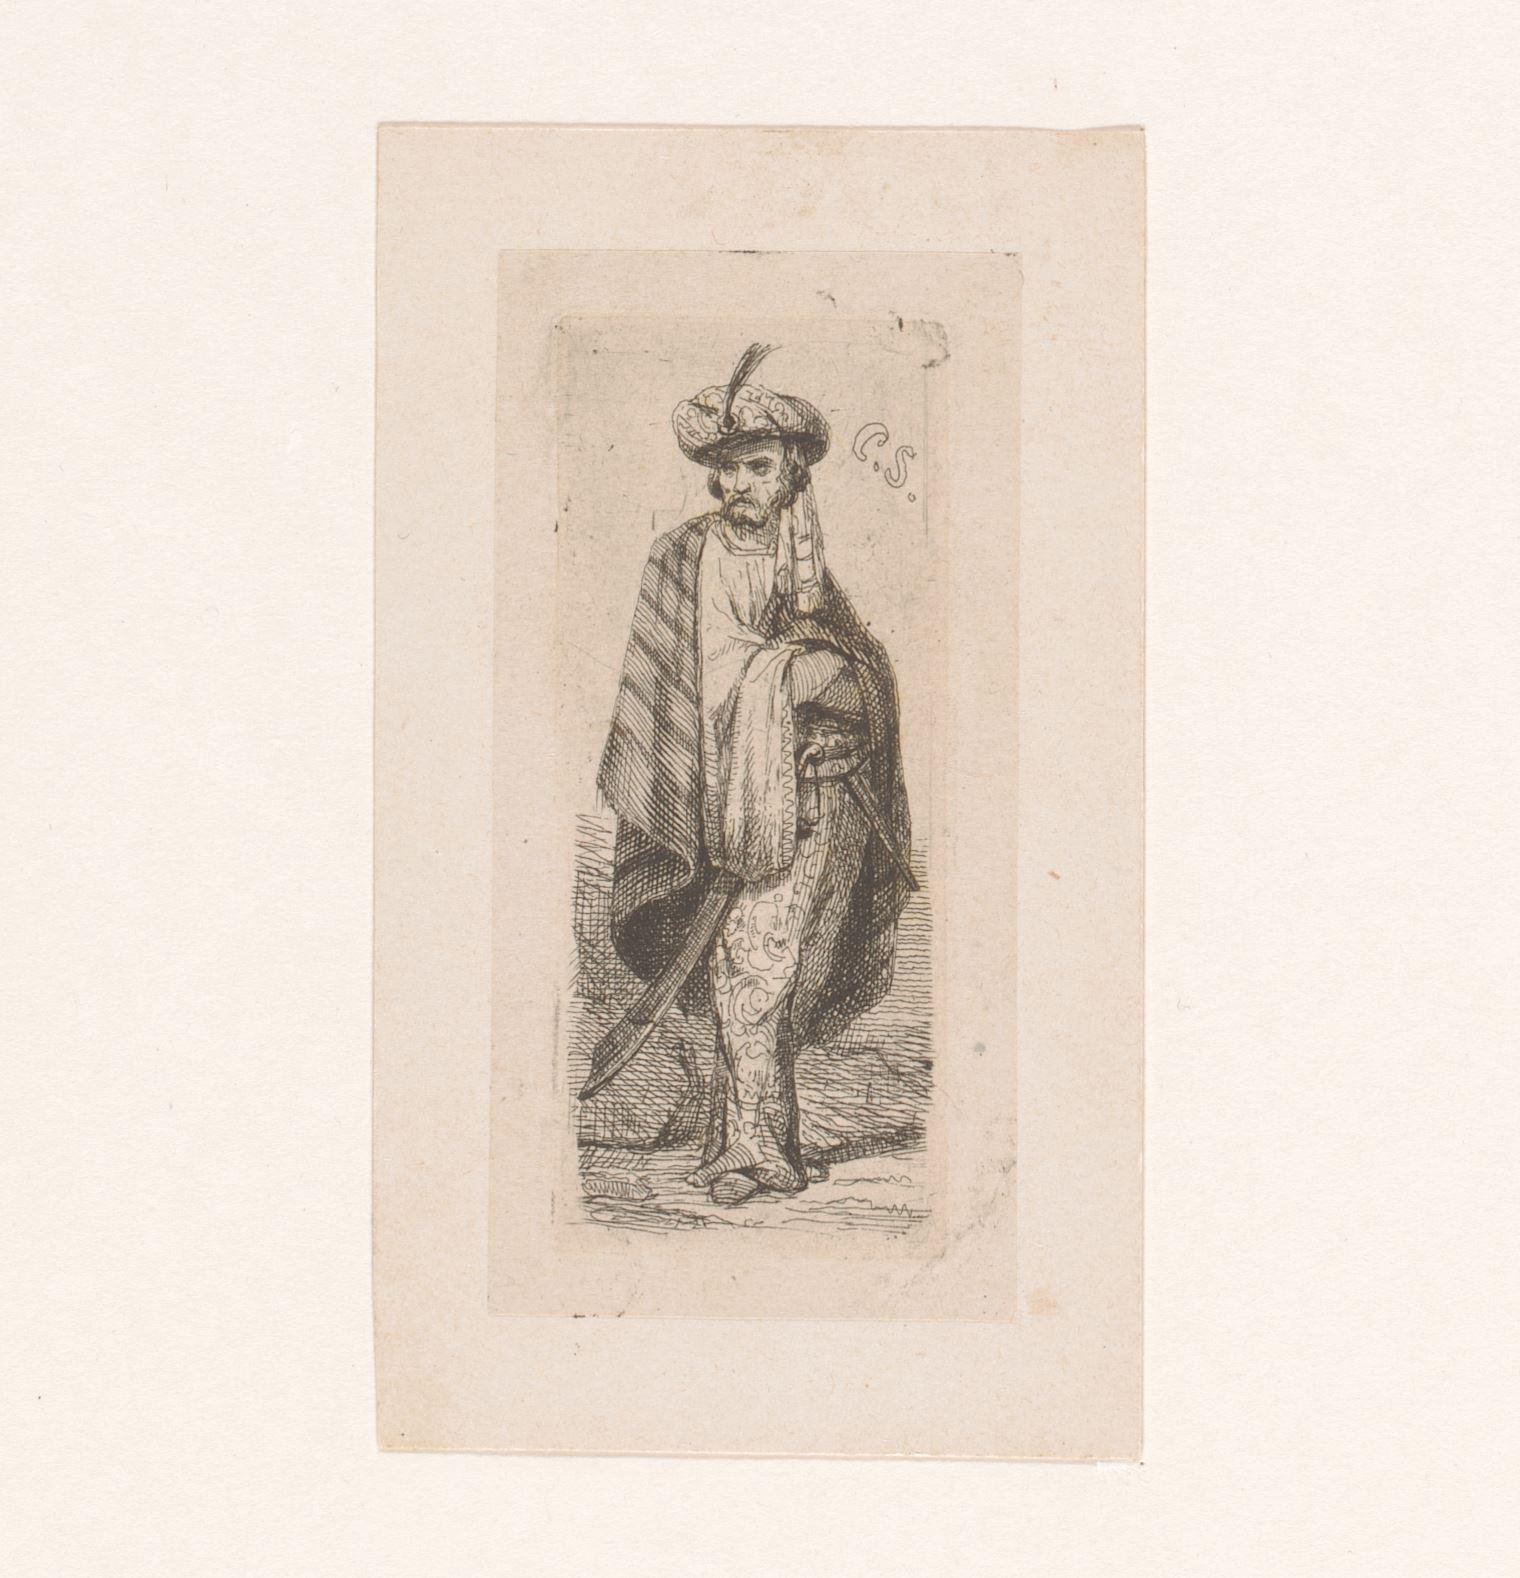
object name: print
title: Man met kromzwaard, tulband en kleding uit het Midden-Oosten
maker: corneille seghers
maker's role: draughtsman, print maker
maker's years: 1814-1869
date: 1824-1869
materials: paper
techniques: etching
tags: hacking and thrusting weapons (with name), head-gear: turban, folk costume, regional costume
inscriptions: collector's mark: Lugt 2228, collector's mark: Lugt 1485